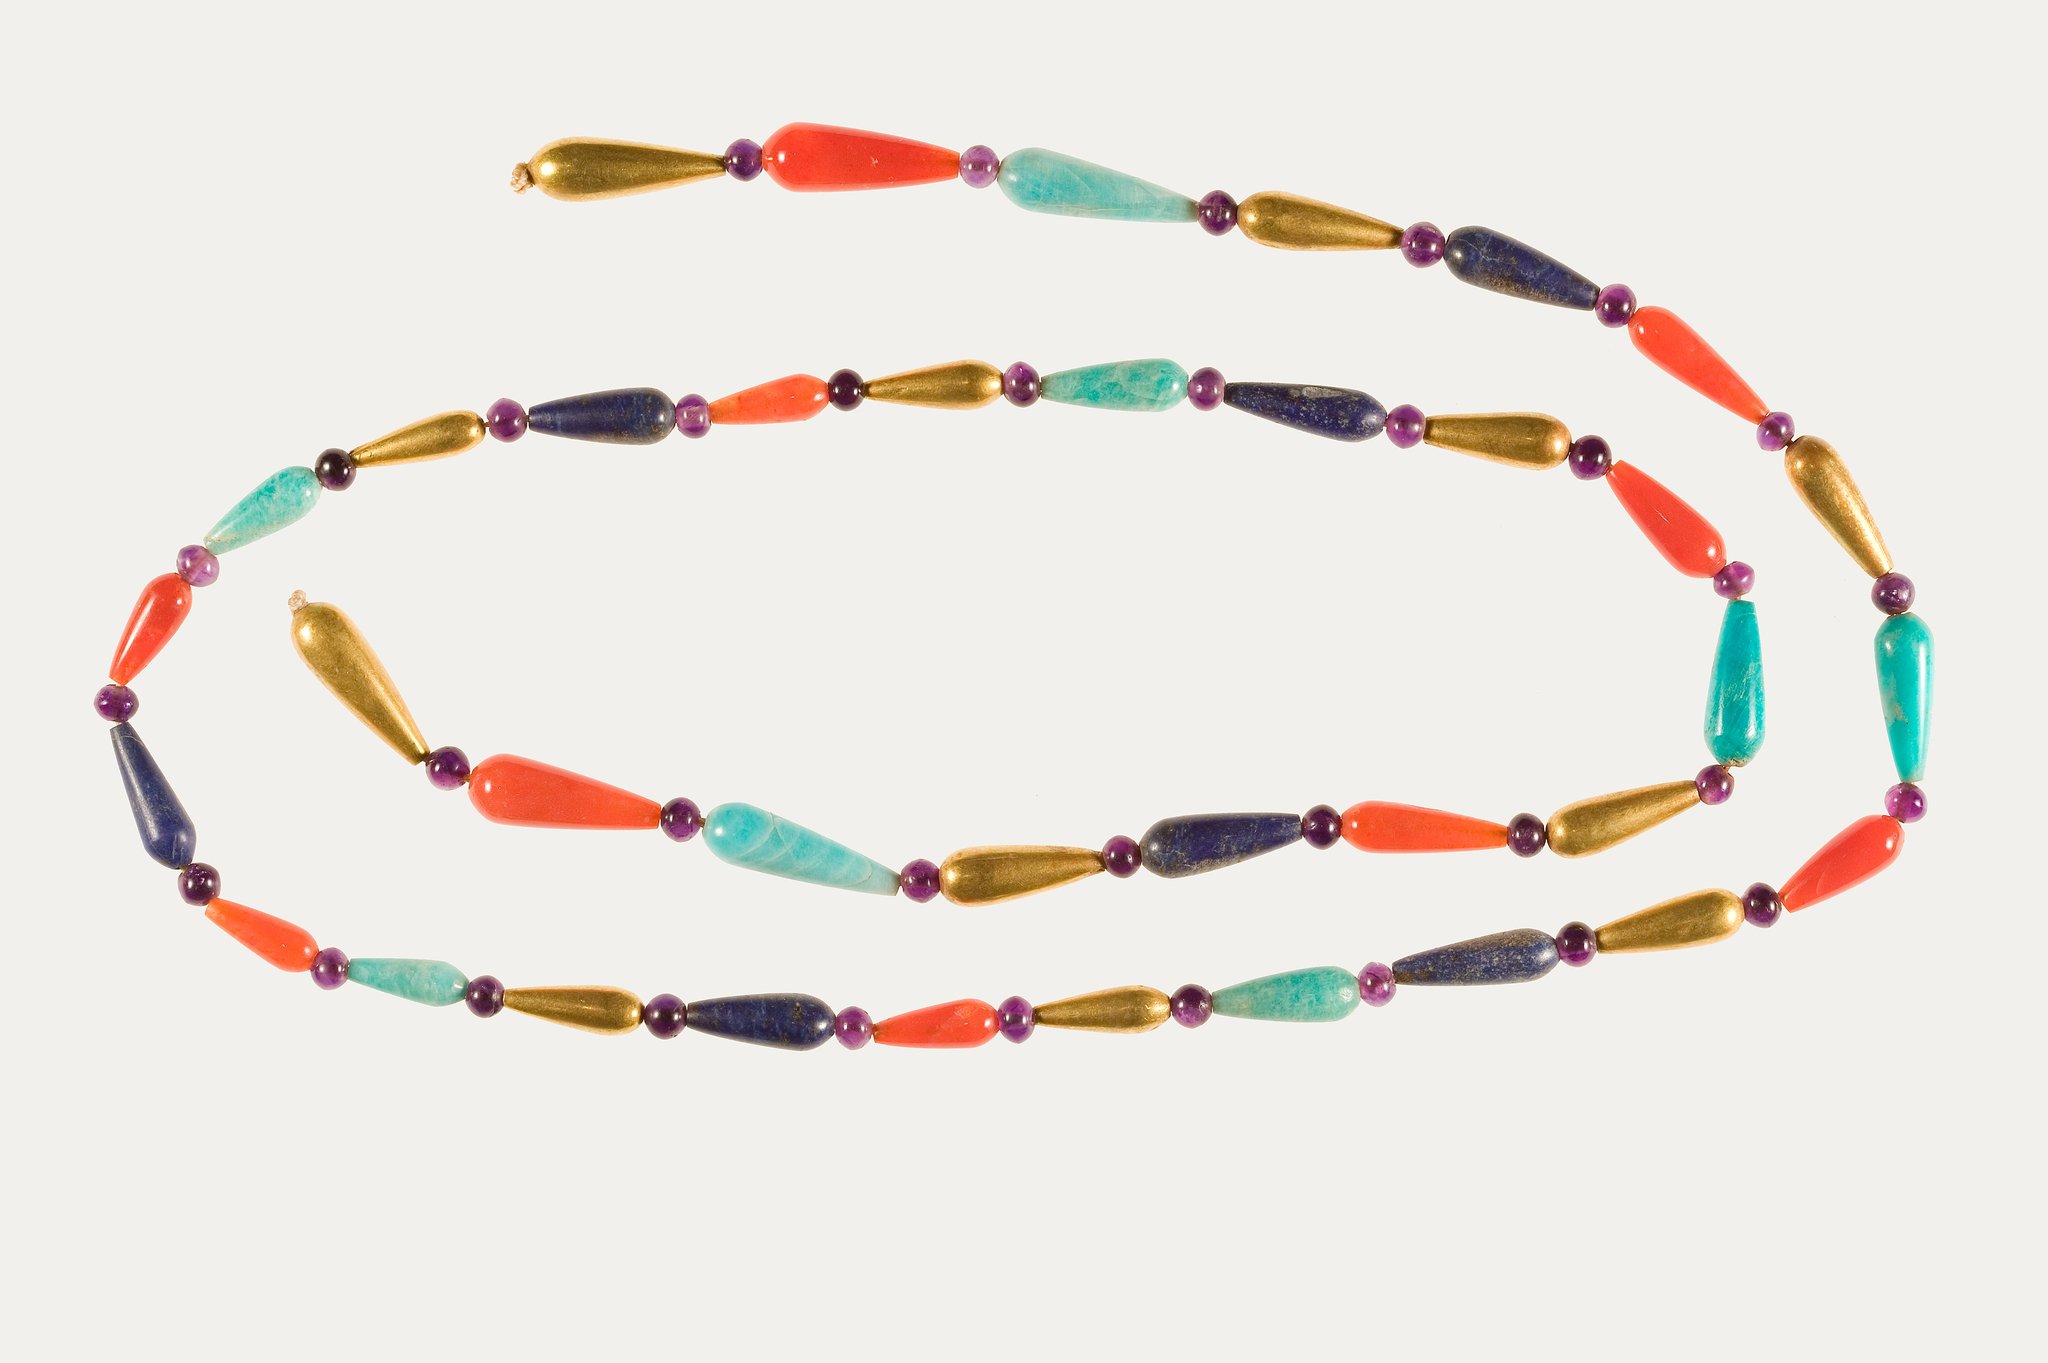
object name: necklace, sithathoryunet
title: Necklace of Sithathoryunet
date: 1887-1813 BCE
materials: gemstone, gold, lapis lazuli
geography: egypt